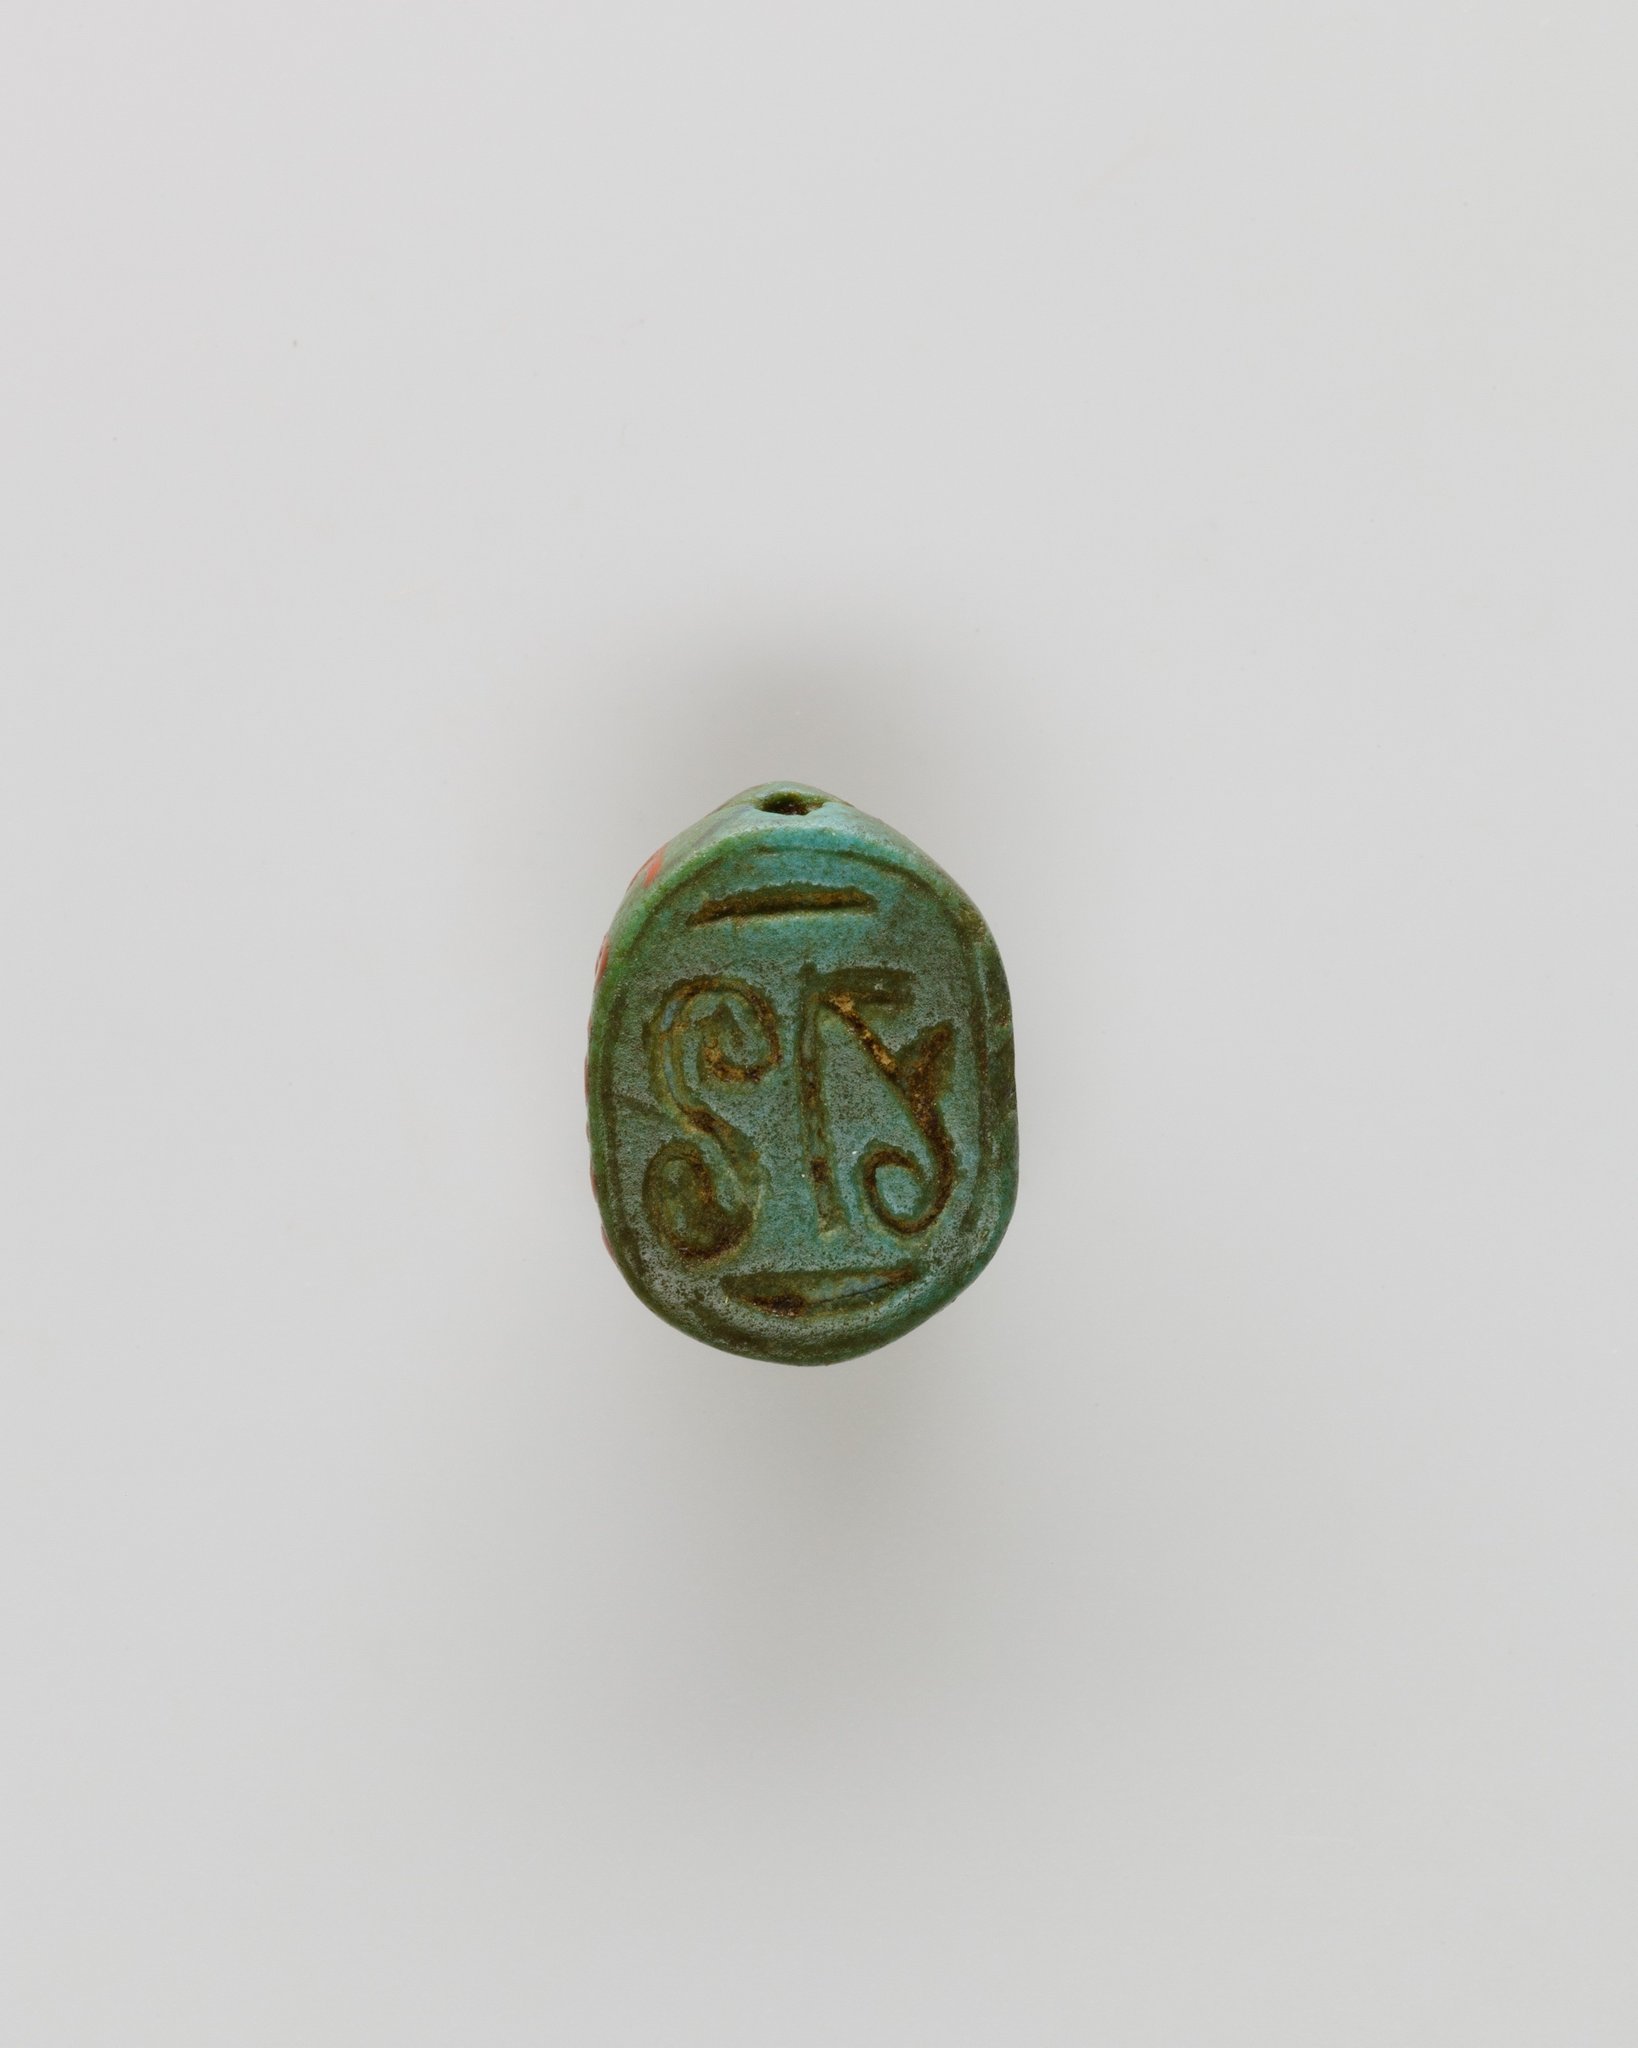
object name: scarab, spiral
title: Scarabs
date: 1492-1473 BCE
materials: stone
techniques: glazing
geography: egypt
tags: hieroglyphs,scarabs